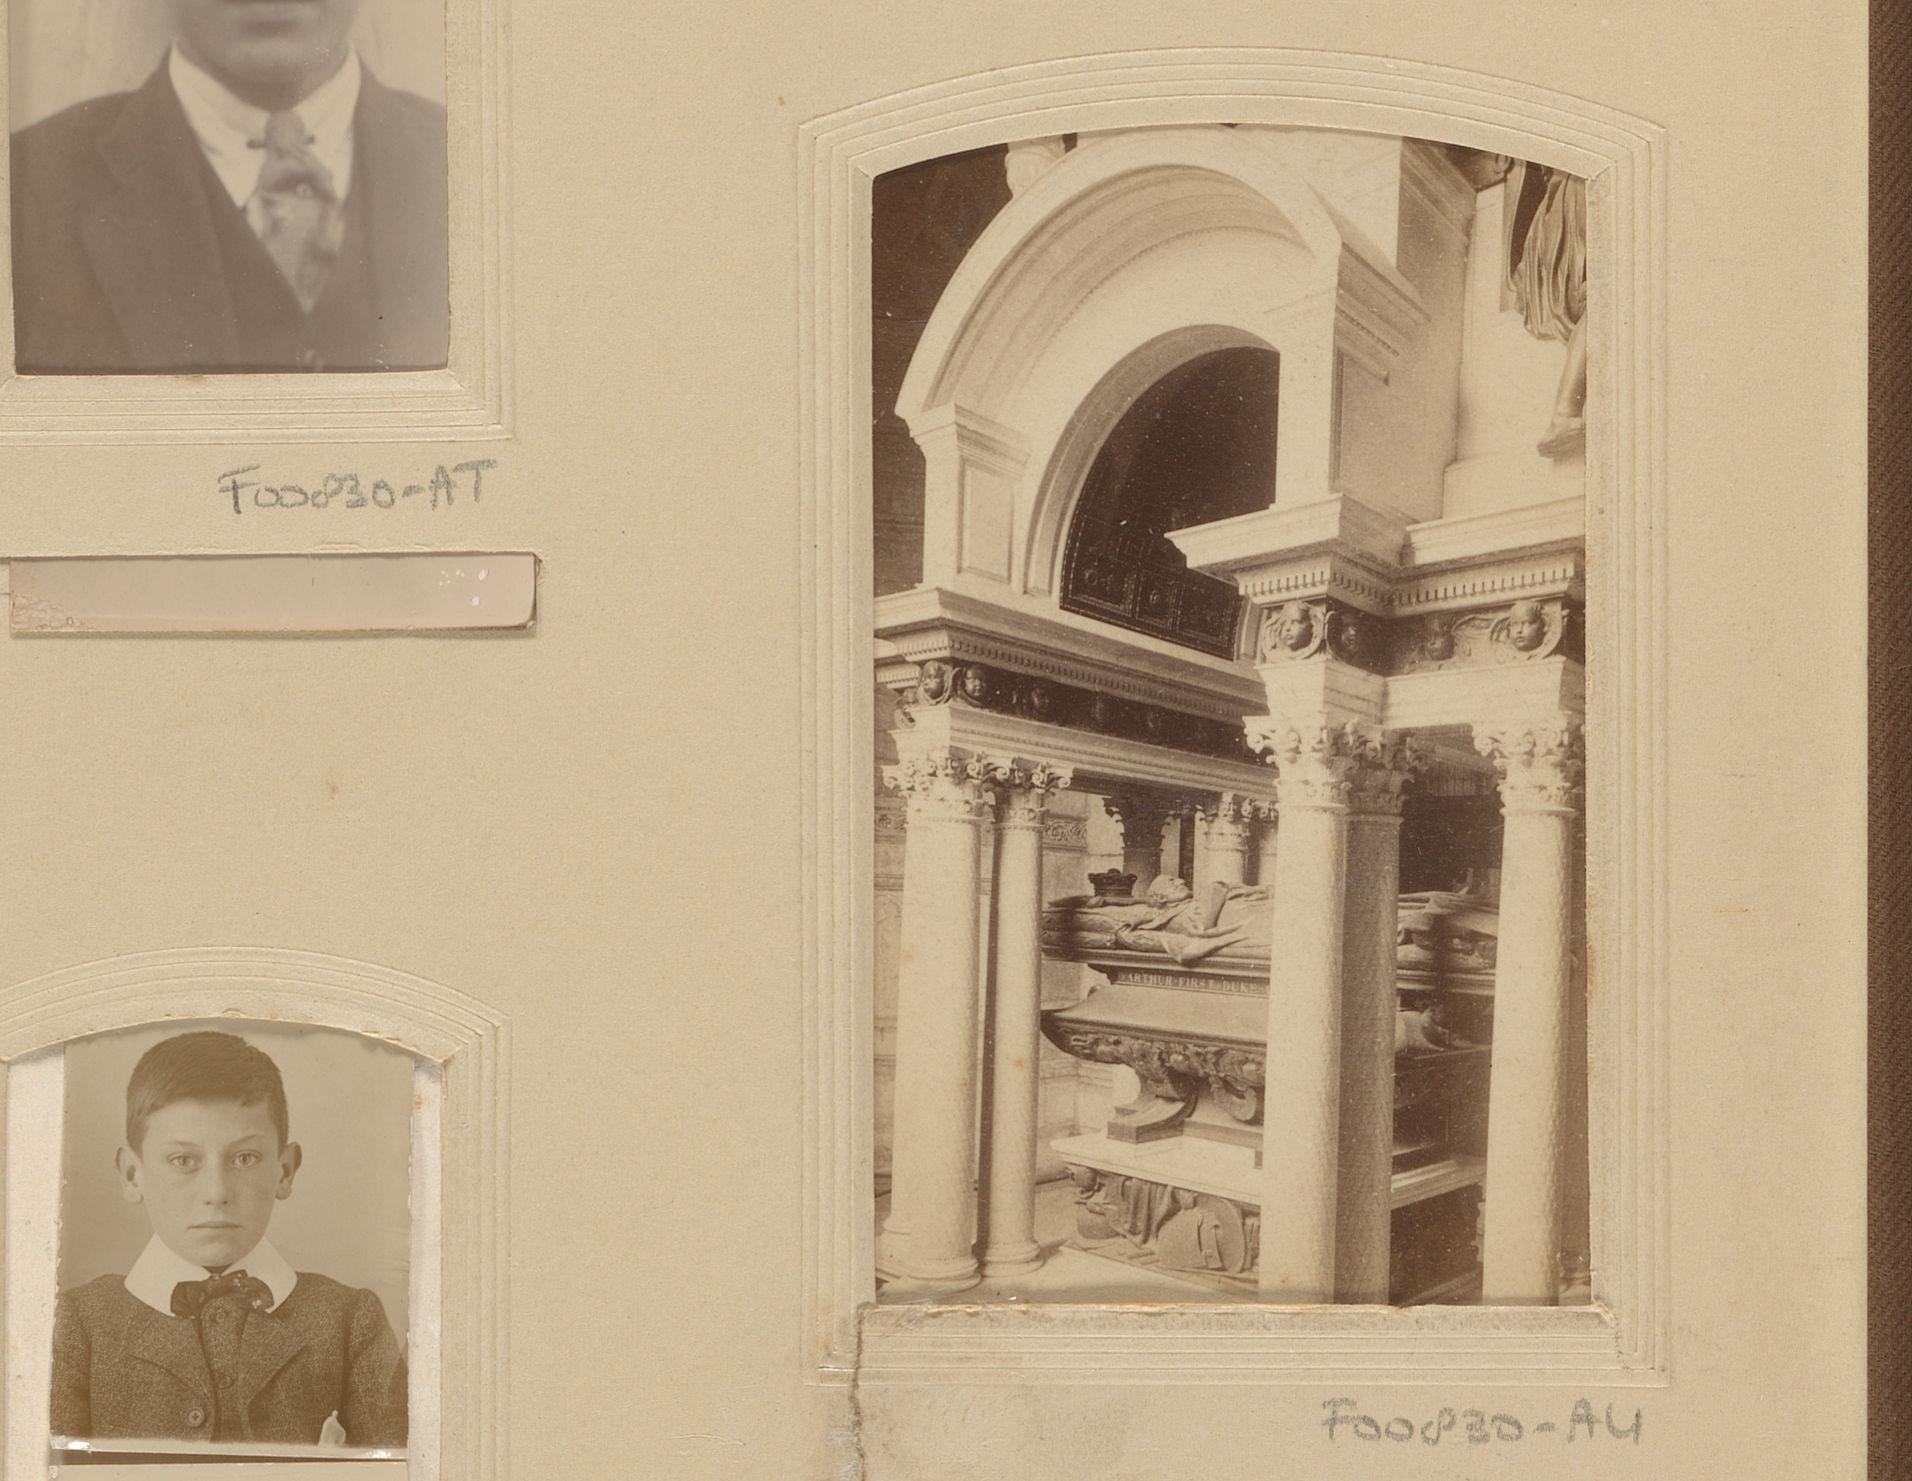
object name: carte de visite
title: Grafmonument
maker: Anonymous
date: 1870-1910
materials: cardboard, photographic support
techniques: albumen print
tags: grave, tomb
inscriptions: annotation: ‘Wellington (...)’, annotation: ‘750/ Wellington Monument’